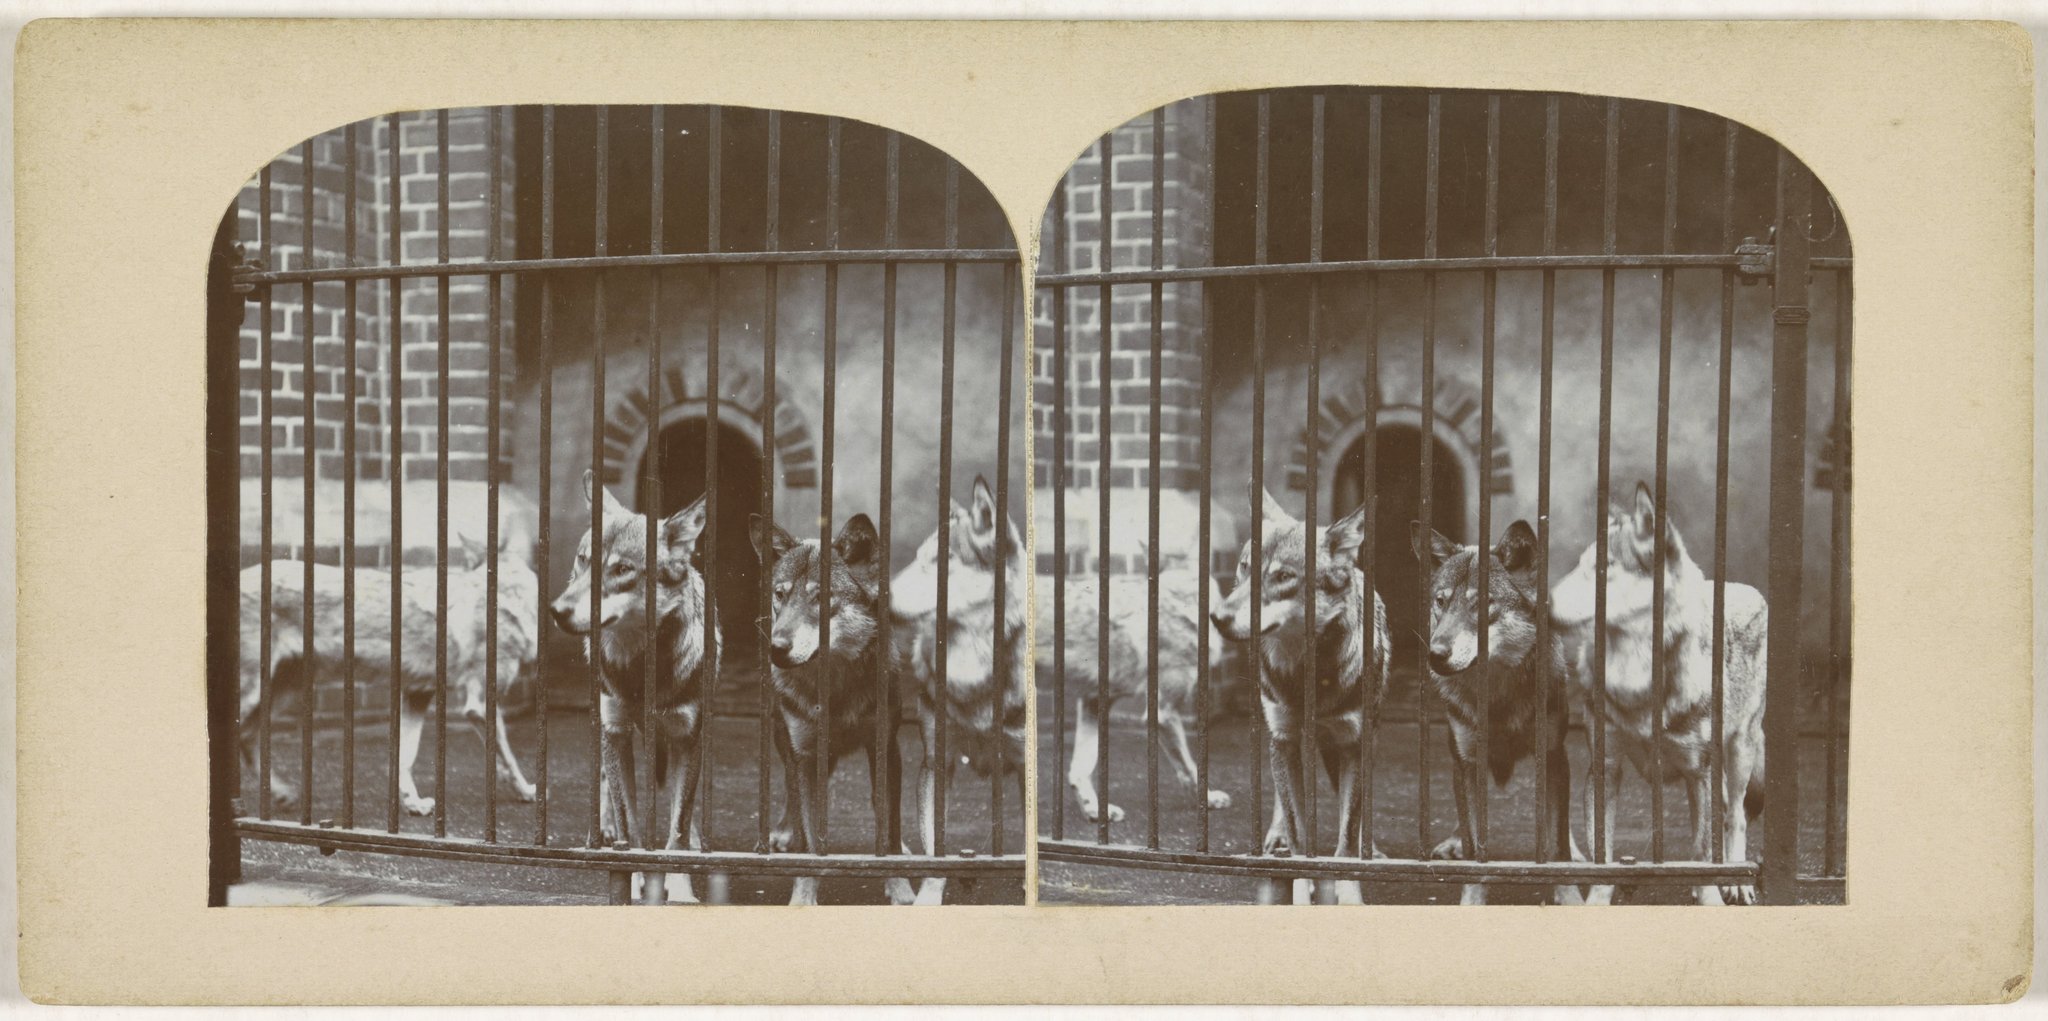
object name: stereograph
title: Wolven in dierentuin (Artis?), Nederland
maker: august frederik willem vogt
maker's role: fotograaf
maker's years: 1871-1922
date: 1920-1940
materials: cardboard, paper, photographic support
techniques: collodion silver print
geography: netherlands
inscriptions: inscription: ‘€7,50’